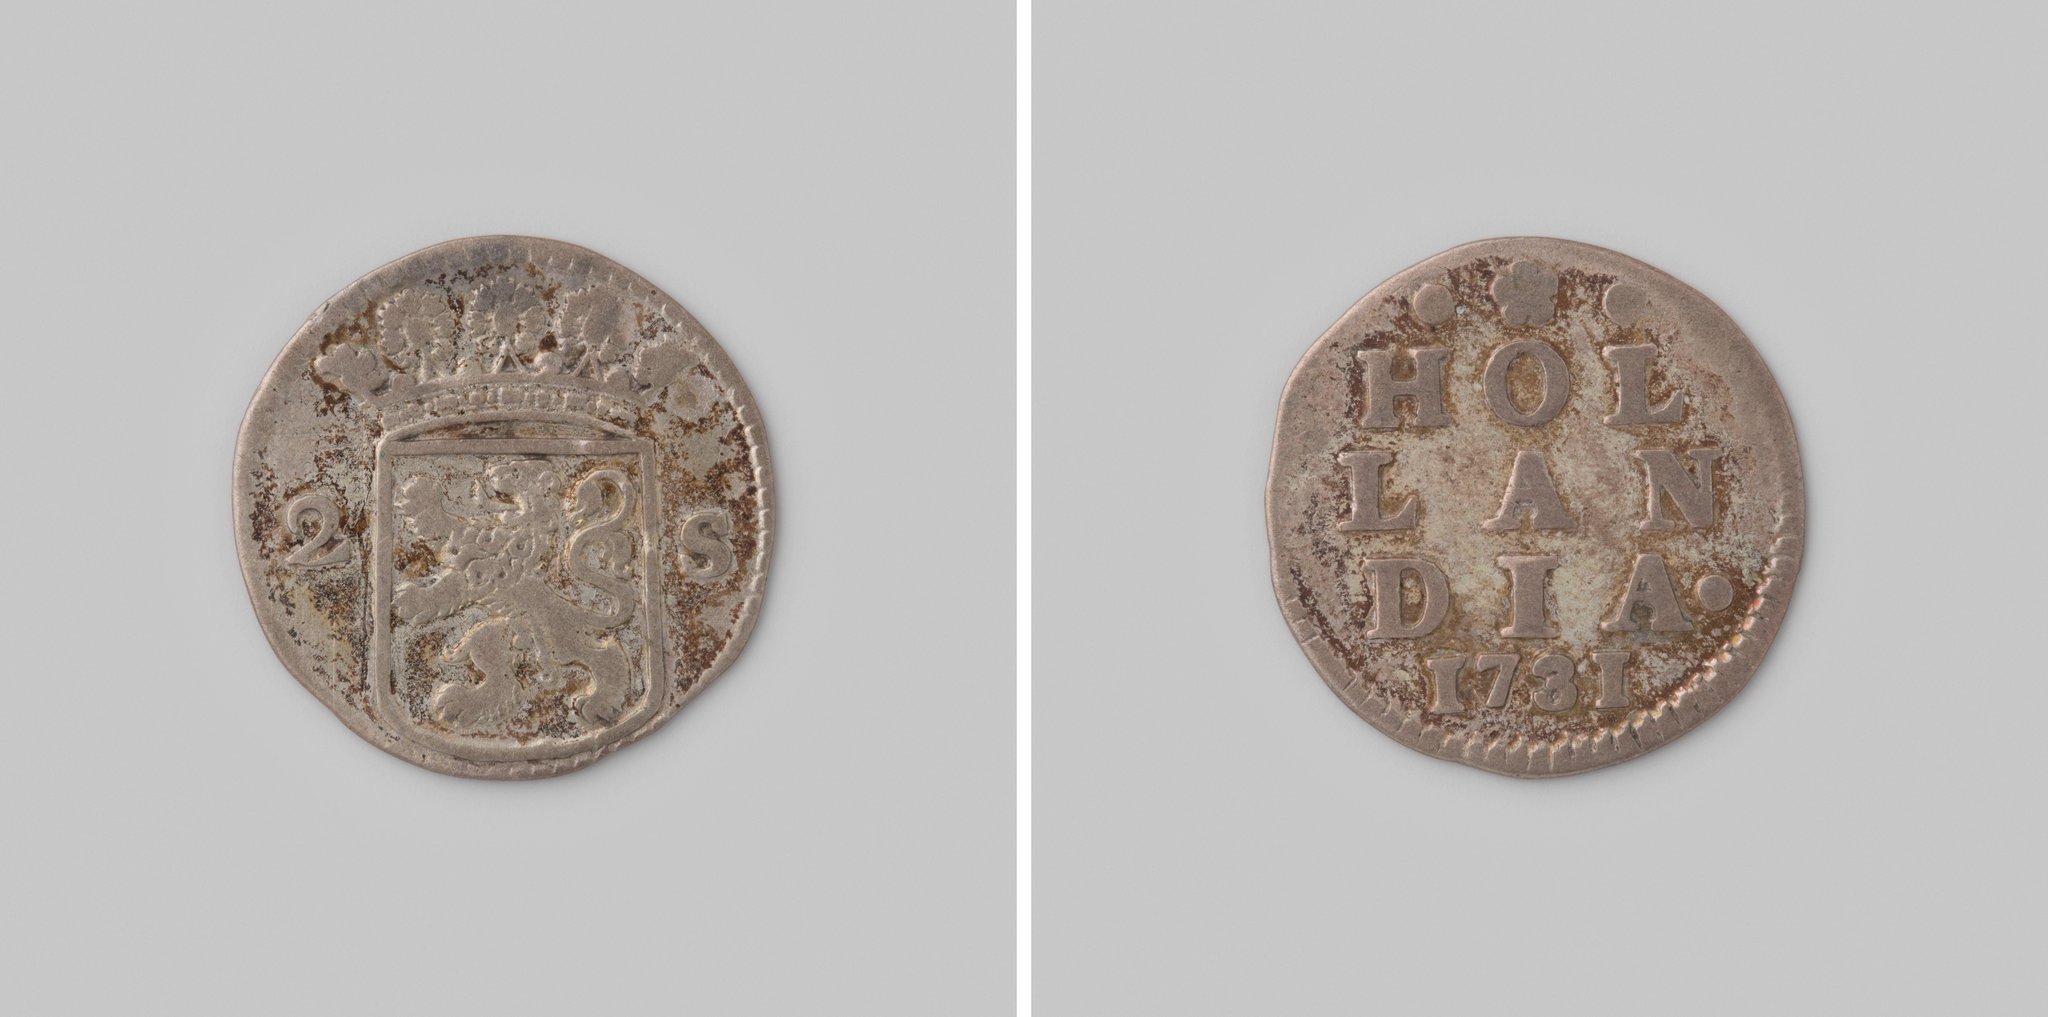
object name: coin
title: Holland, dubbele stuiver, 1731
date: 1731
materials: silver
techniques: striking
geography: dordrecht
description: Zilveren munt. Voorzijde: tussen waarde-aanduiding 2 S gekroond wapenschild van Holland. Keerzijde: opschrift: provincienaam in drie regels, daaronder jaartal.